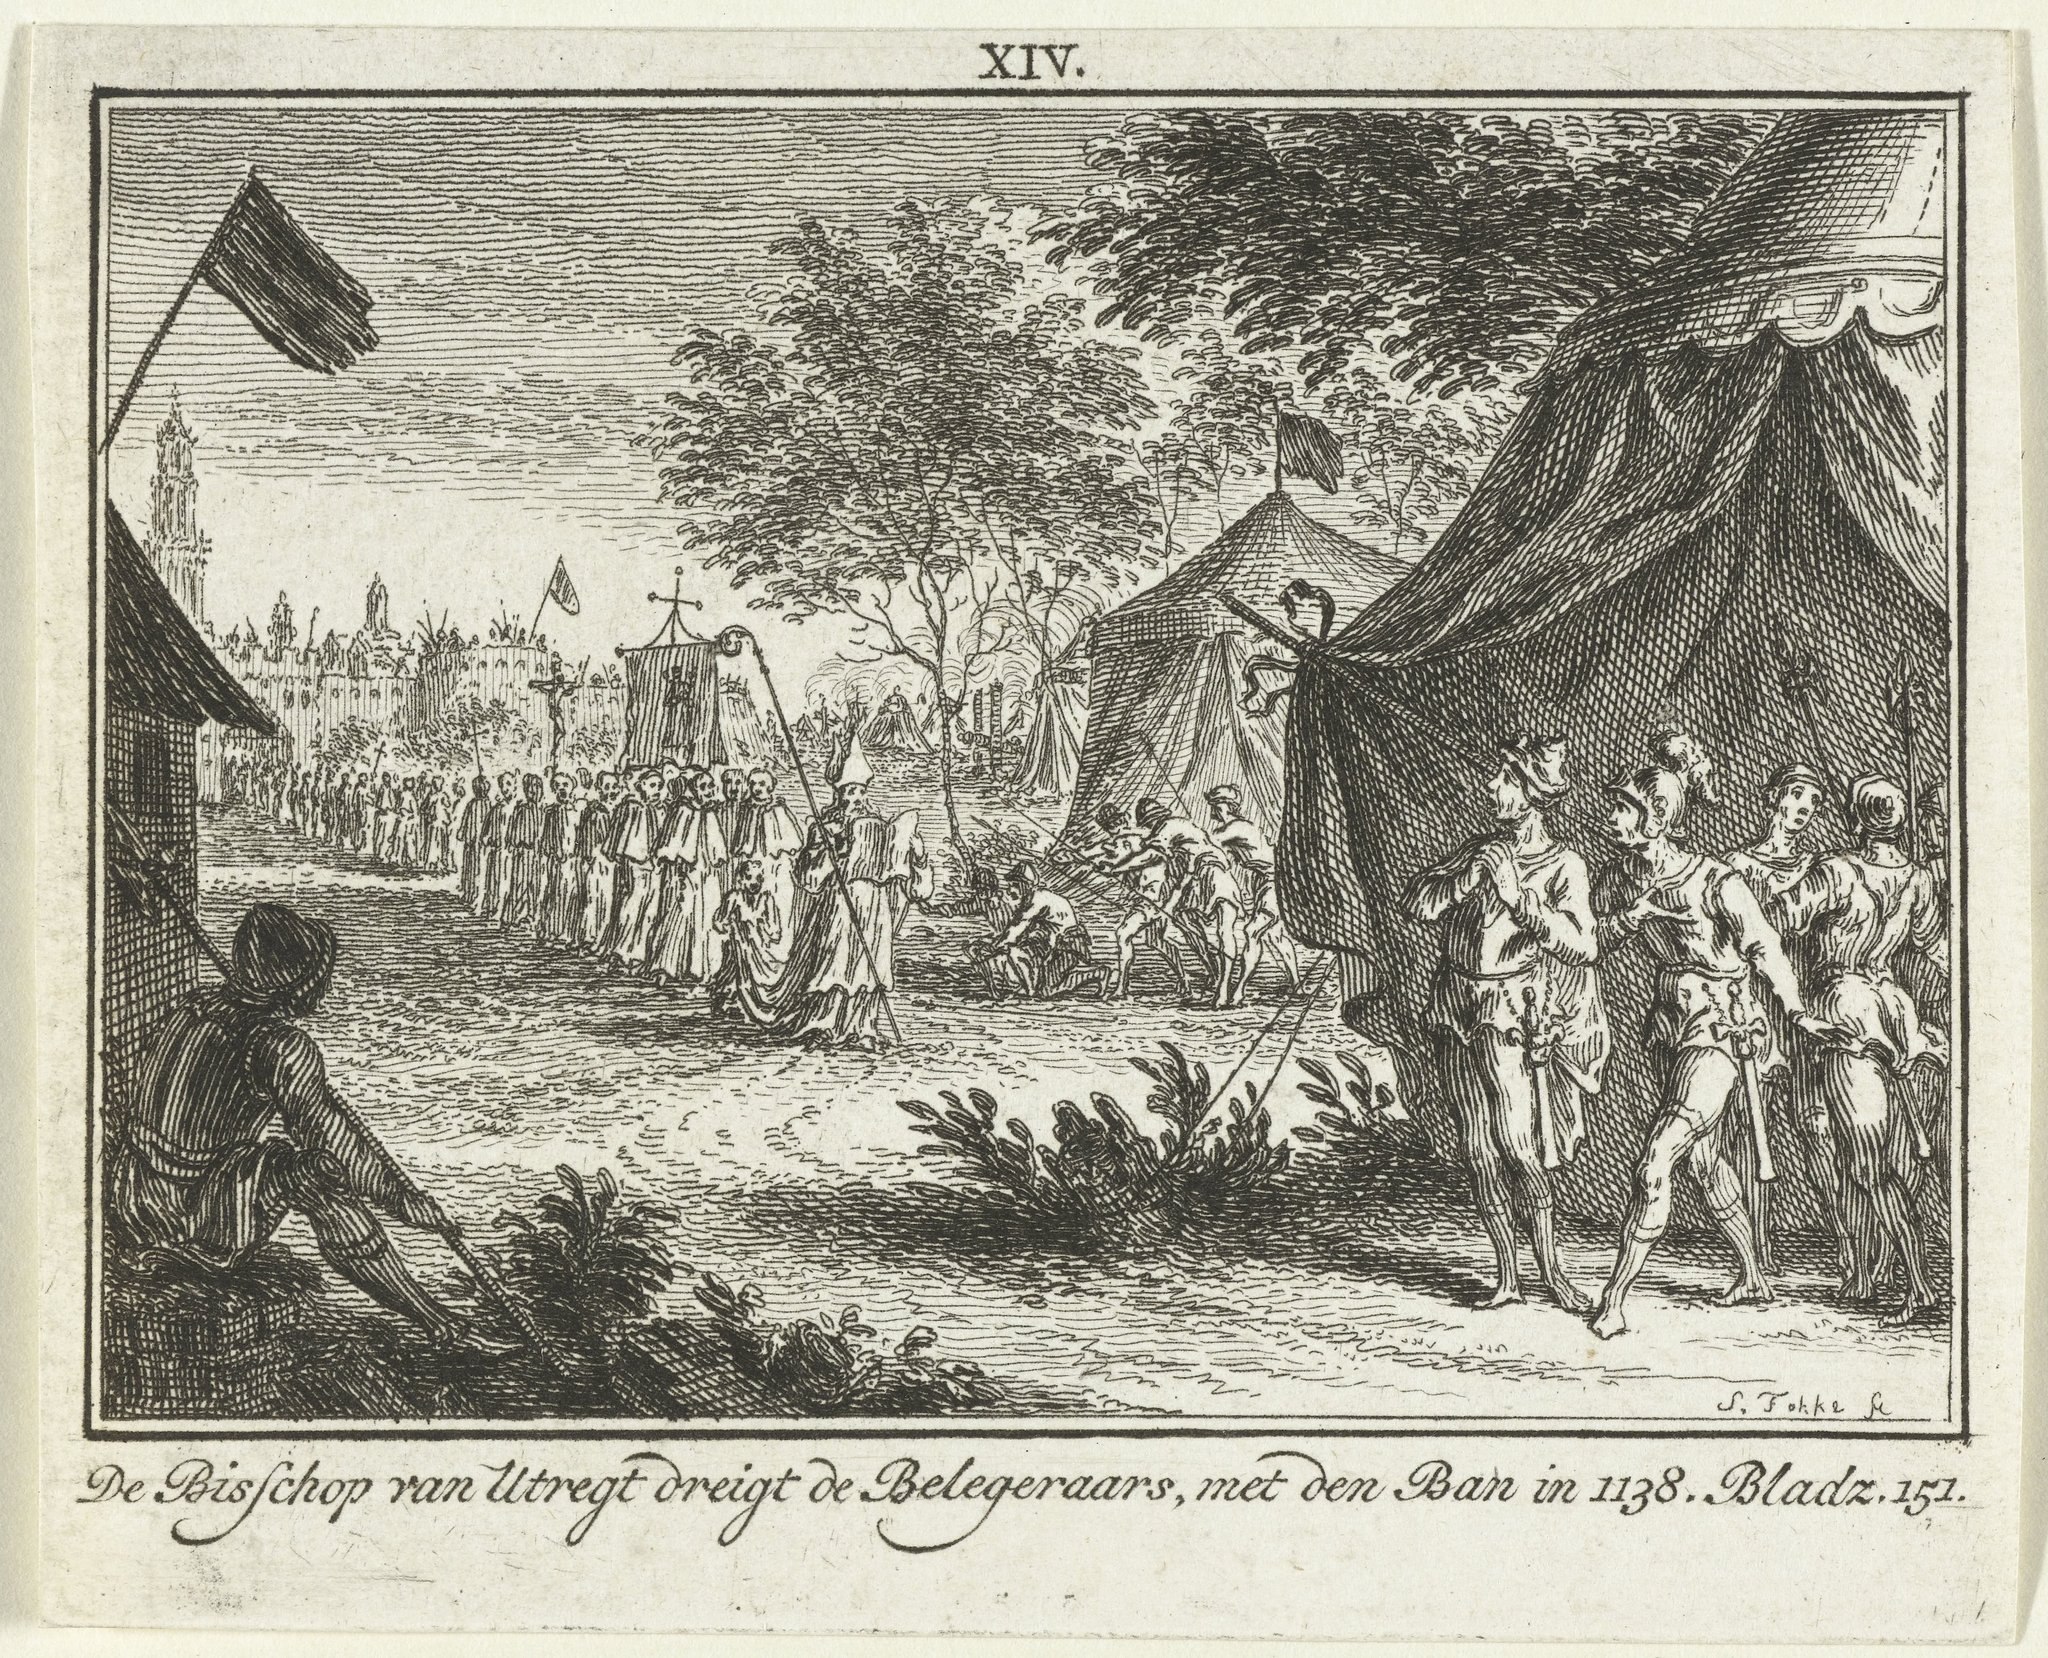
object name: print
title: De Bisschop van Utregt dreigt de Belegeraars, met den Ban in 1138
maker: simon fokke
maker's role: draughtsman, print maker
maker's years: 1712-1784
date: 1722-1750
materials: paper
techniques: etching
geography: northern netherlands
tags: excommunication, utrecht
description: Illustratie voor een onbekend werk, later hergebruikt in: J.W. te Water, De vaderlandsche Historie van den heere J. Wagenaar, verkort, en met leerzaame aanmerkingen, ten dienste der Nederlandsche jeugd, 1784-1800, 4 delen. Pl. XIV, blz. 151. Staat met de letter.